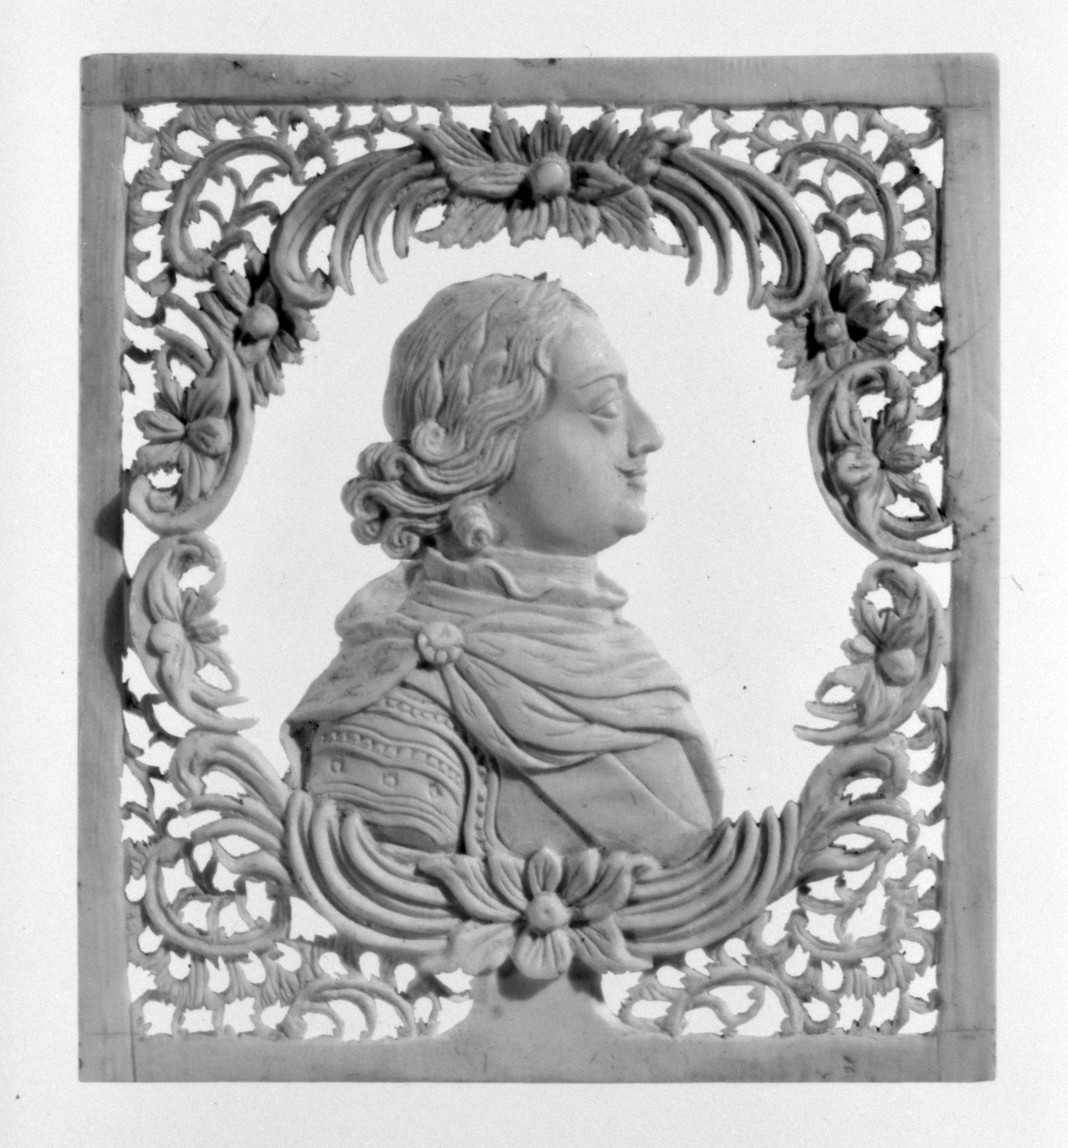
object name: plaque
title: Peter the Great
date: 1767-1833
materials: ivory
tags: men,profiles